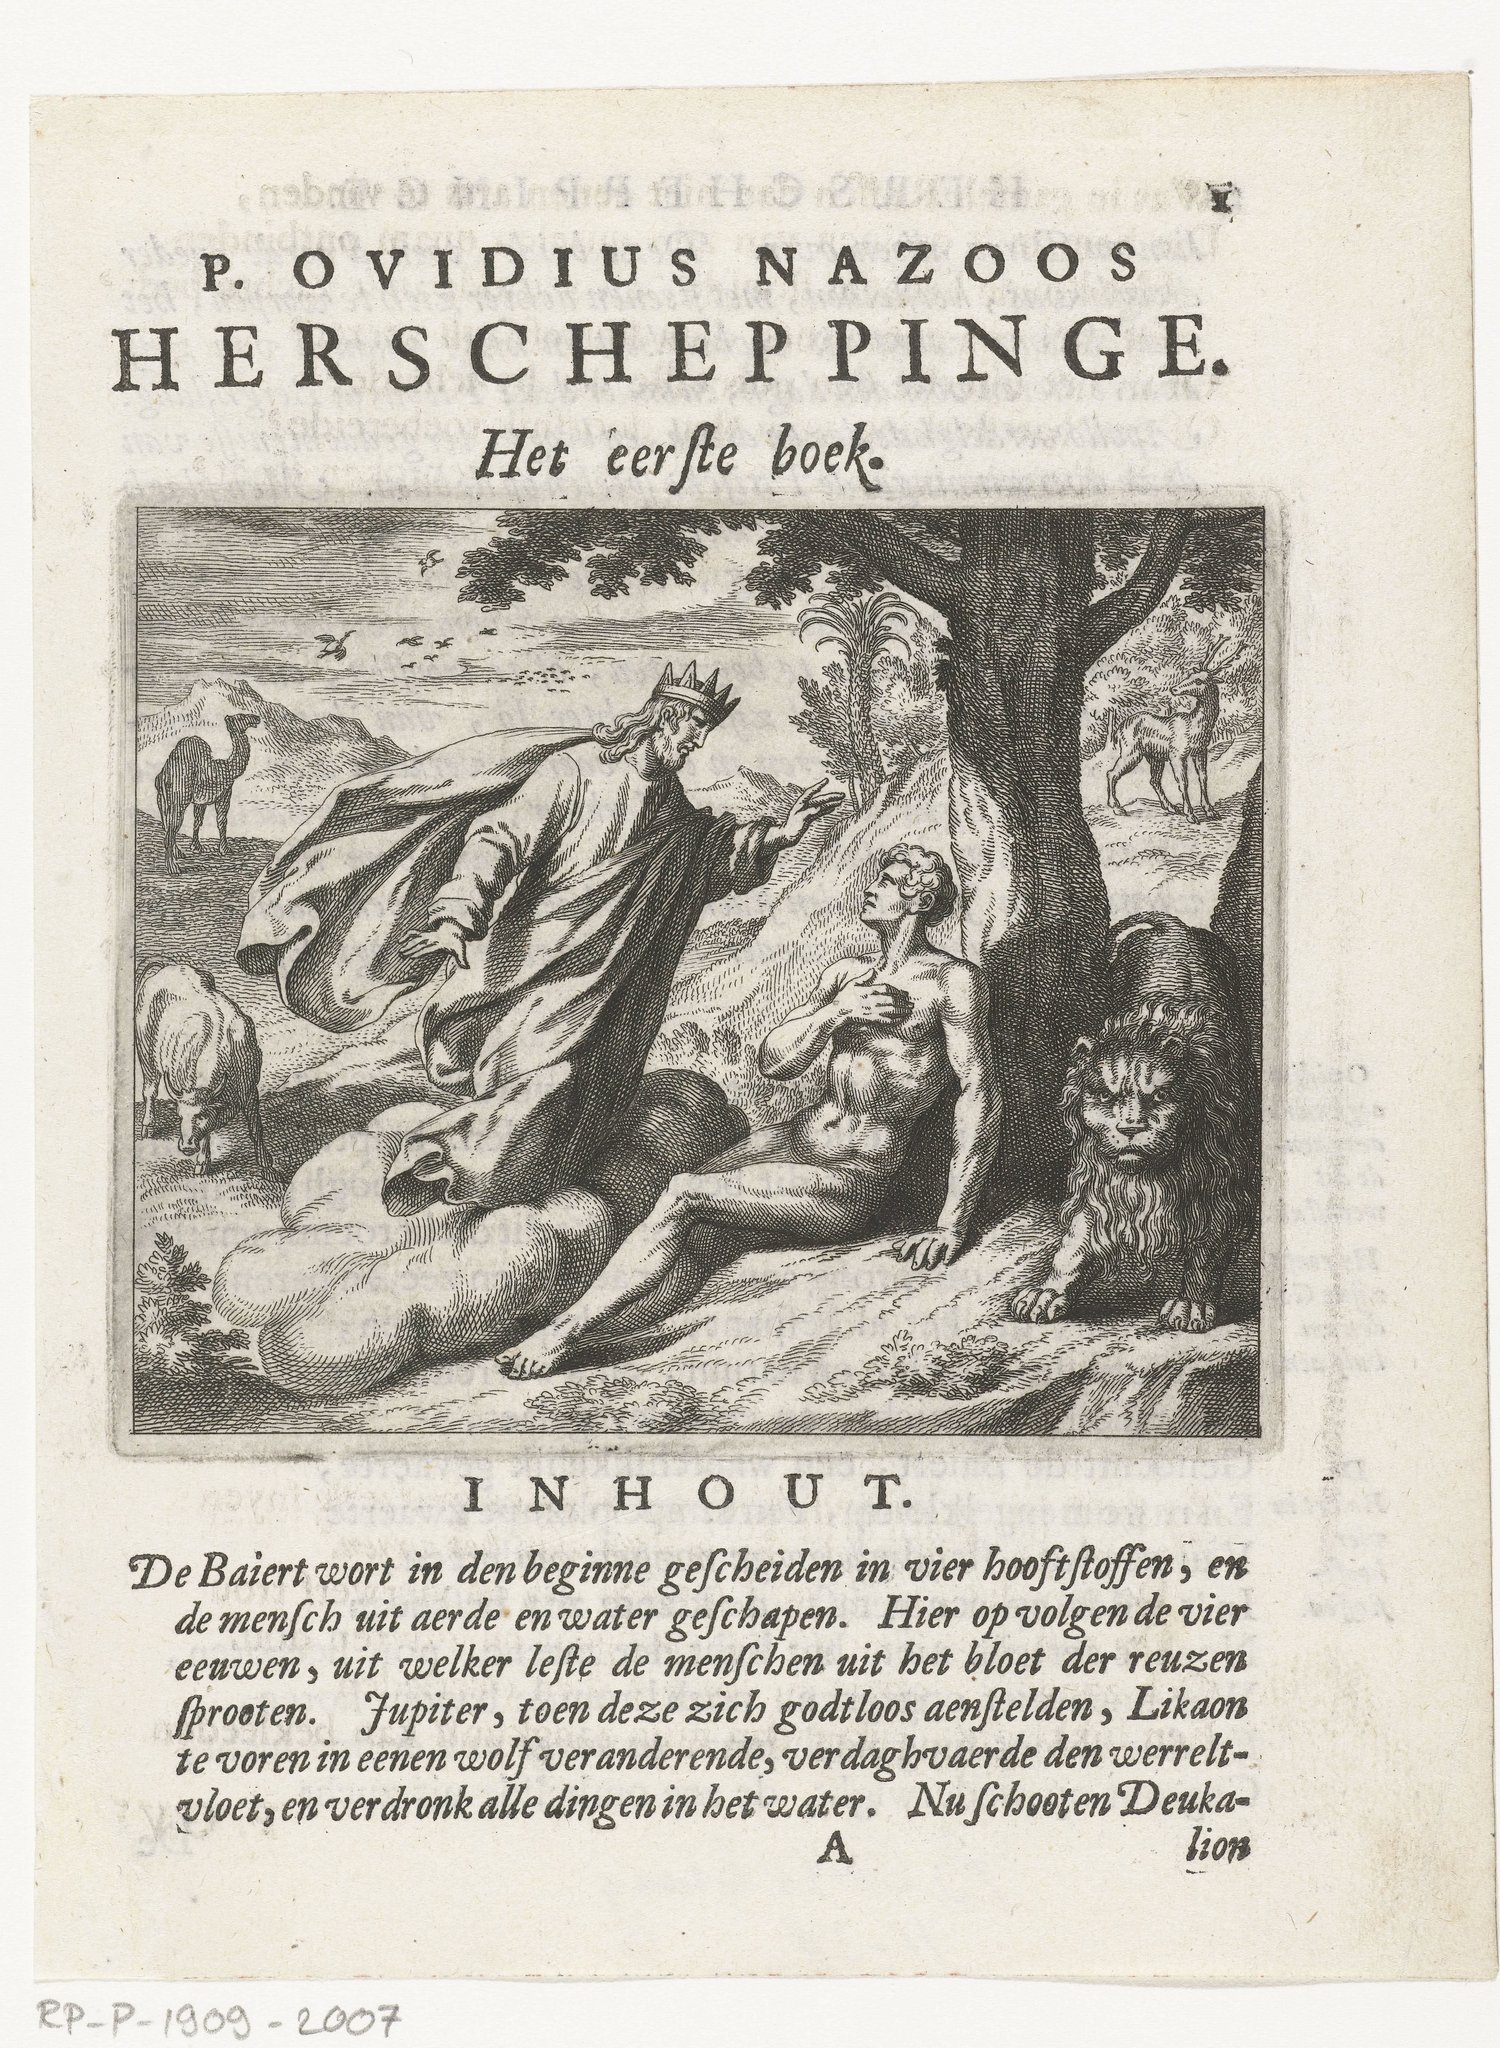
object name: print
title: Herscheppinge van Publius Ovidius Naso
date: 1671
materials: paper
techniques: etching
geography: amsterdam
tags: origin of man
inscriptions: collector's mark: Lugt 2228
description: Bladzijde uit een boek met tekst op recto en verso en een illustratie aan het begin van boek 1. God schept de mens. Hij staat op een wolk en draagt een kroon. De mens ligt naakt tegen een boom geleund. Om hem heen lopen dieren, een leeuw, hert, stier en een kameel.